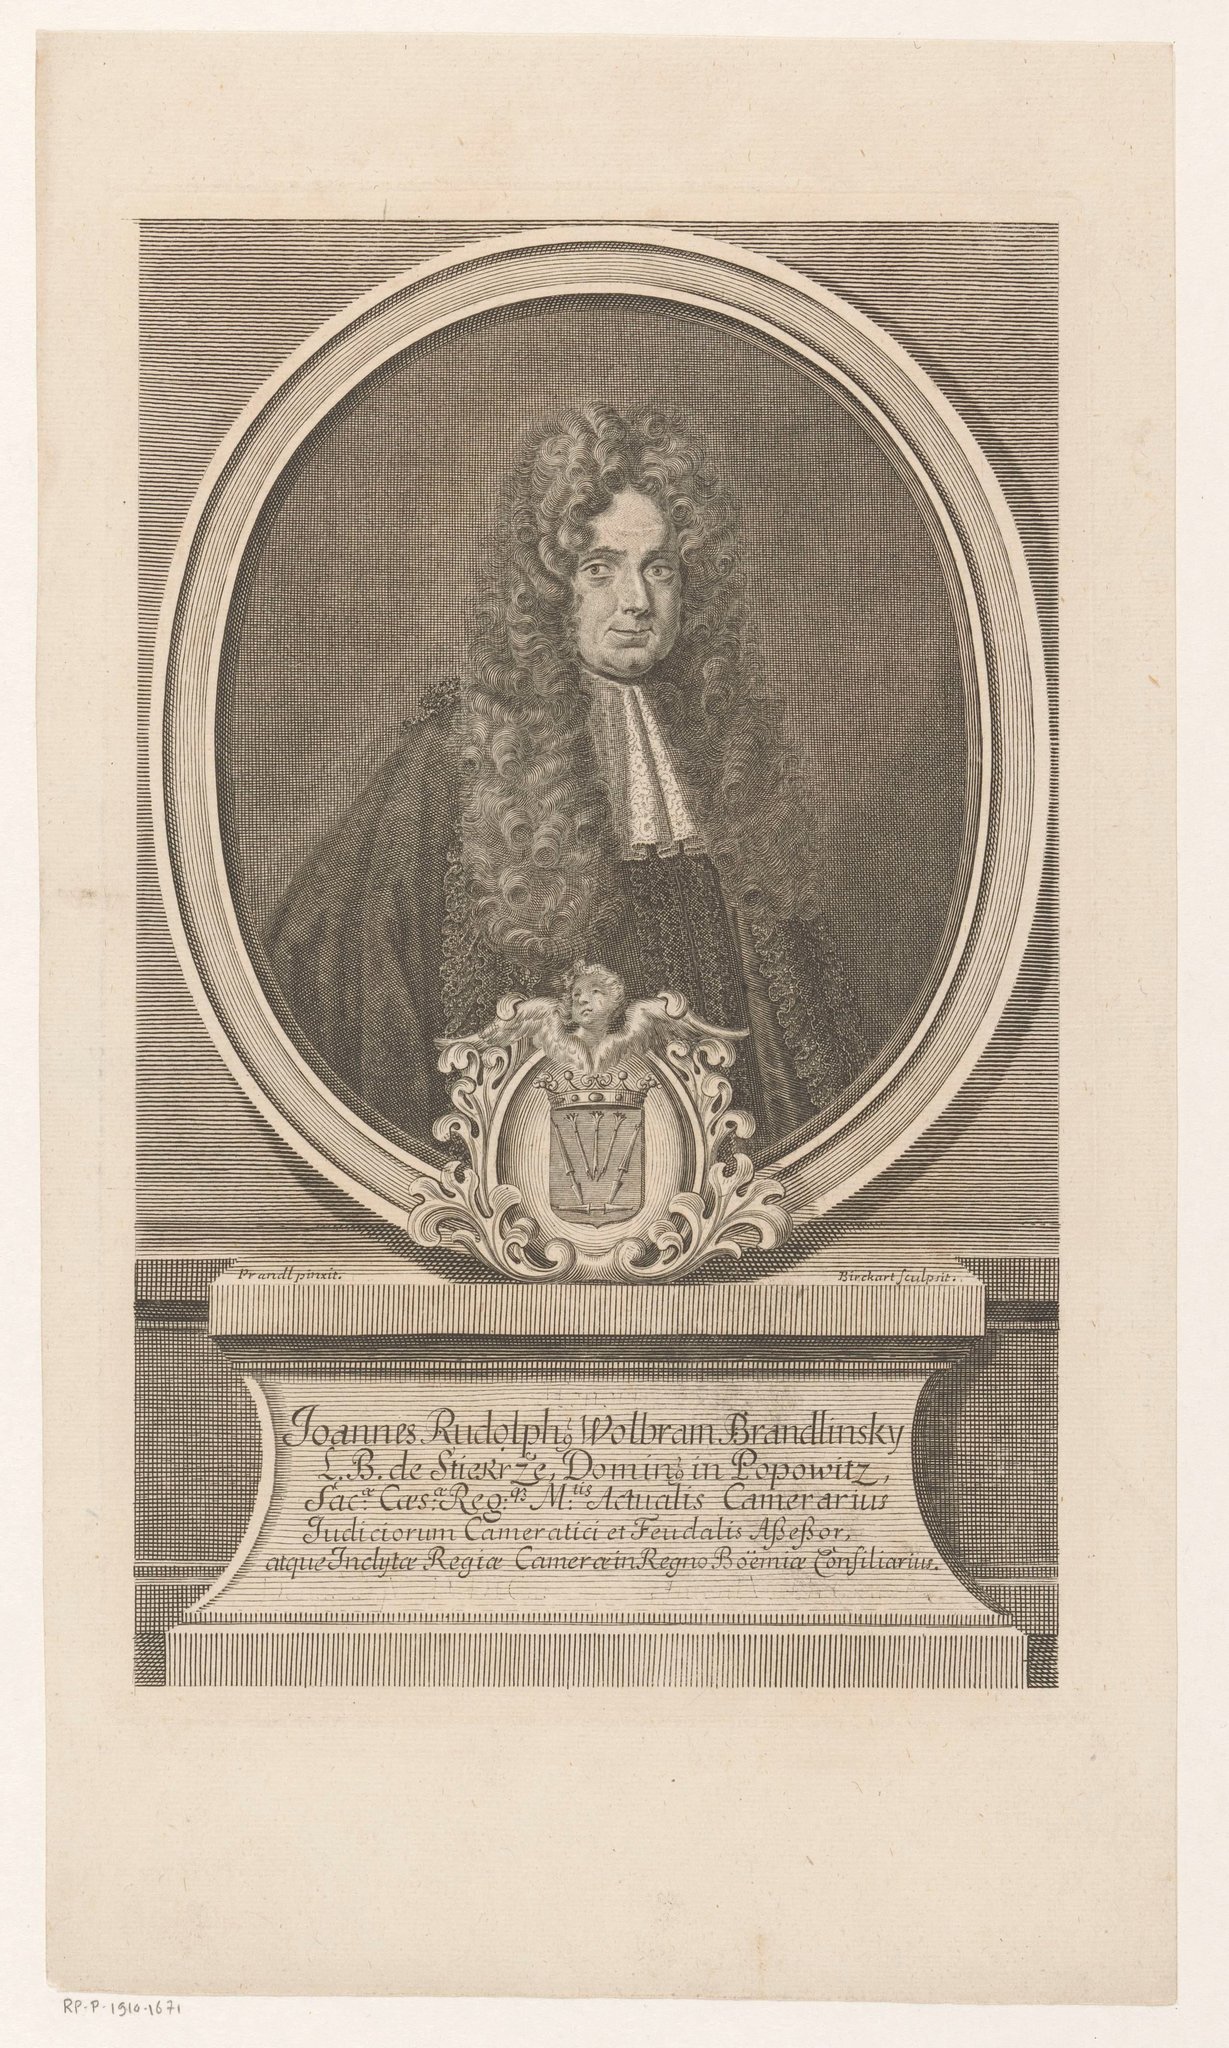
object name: print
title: Portret van Johann Rudolph Walram Brandlinsky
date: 1720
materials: paper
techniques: engraving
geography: prague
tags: historical persons, armorial bearing, heraldry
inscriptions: collector's mark: Lugt 2228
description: Prent ook gebruikt in: Theatrum Europaeum. dl. 18. Frankfurt am Main: erven Cal Gustav Merian, 1720.